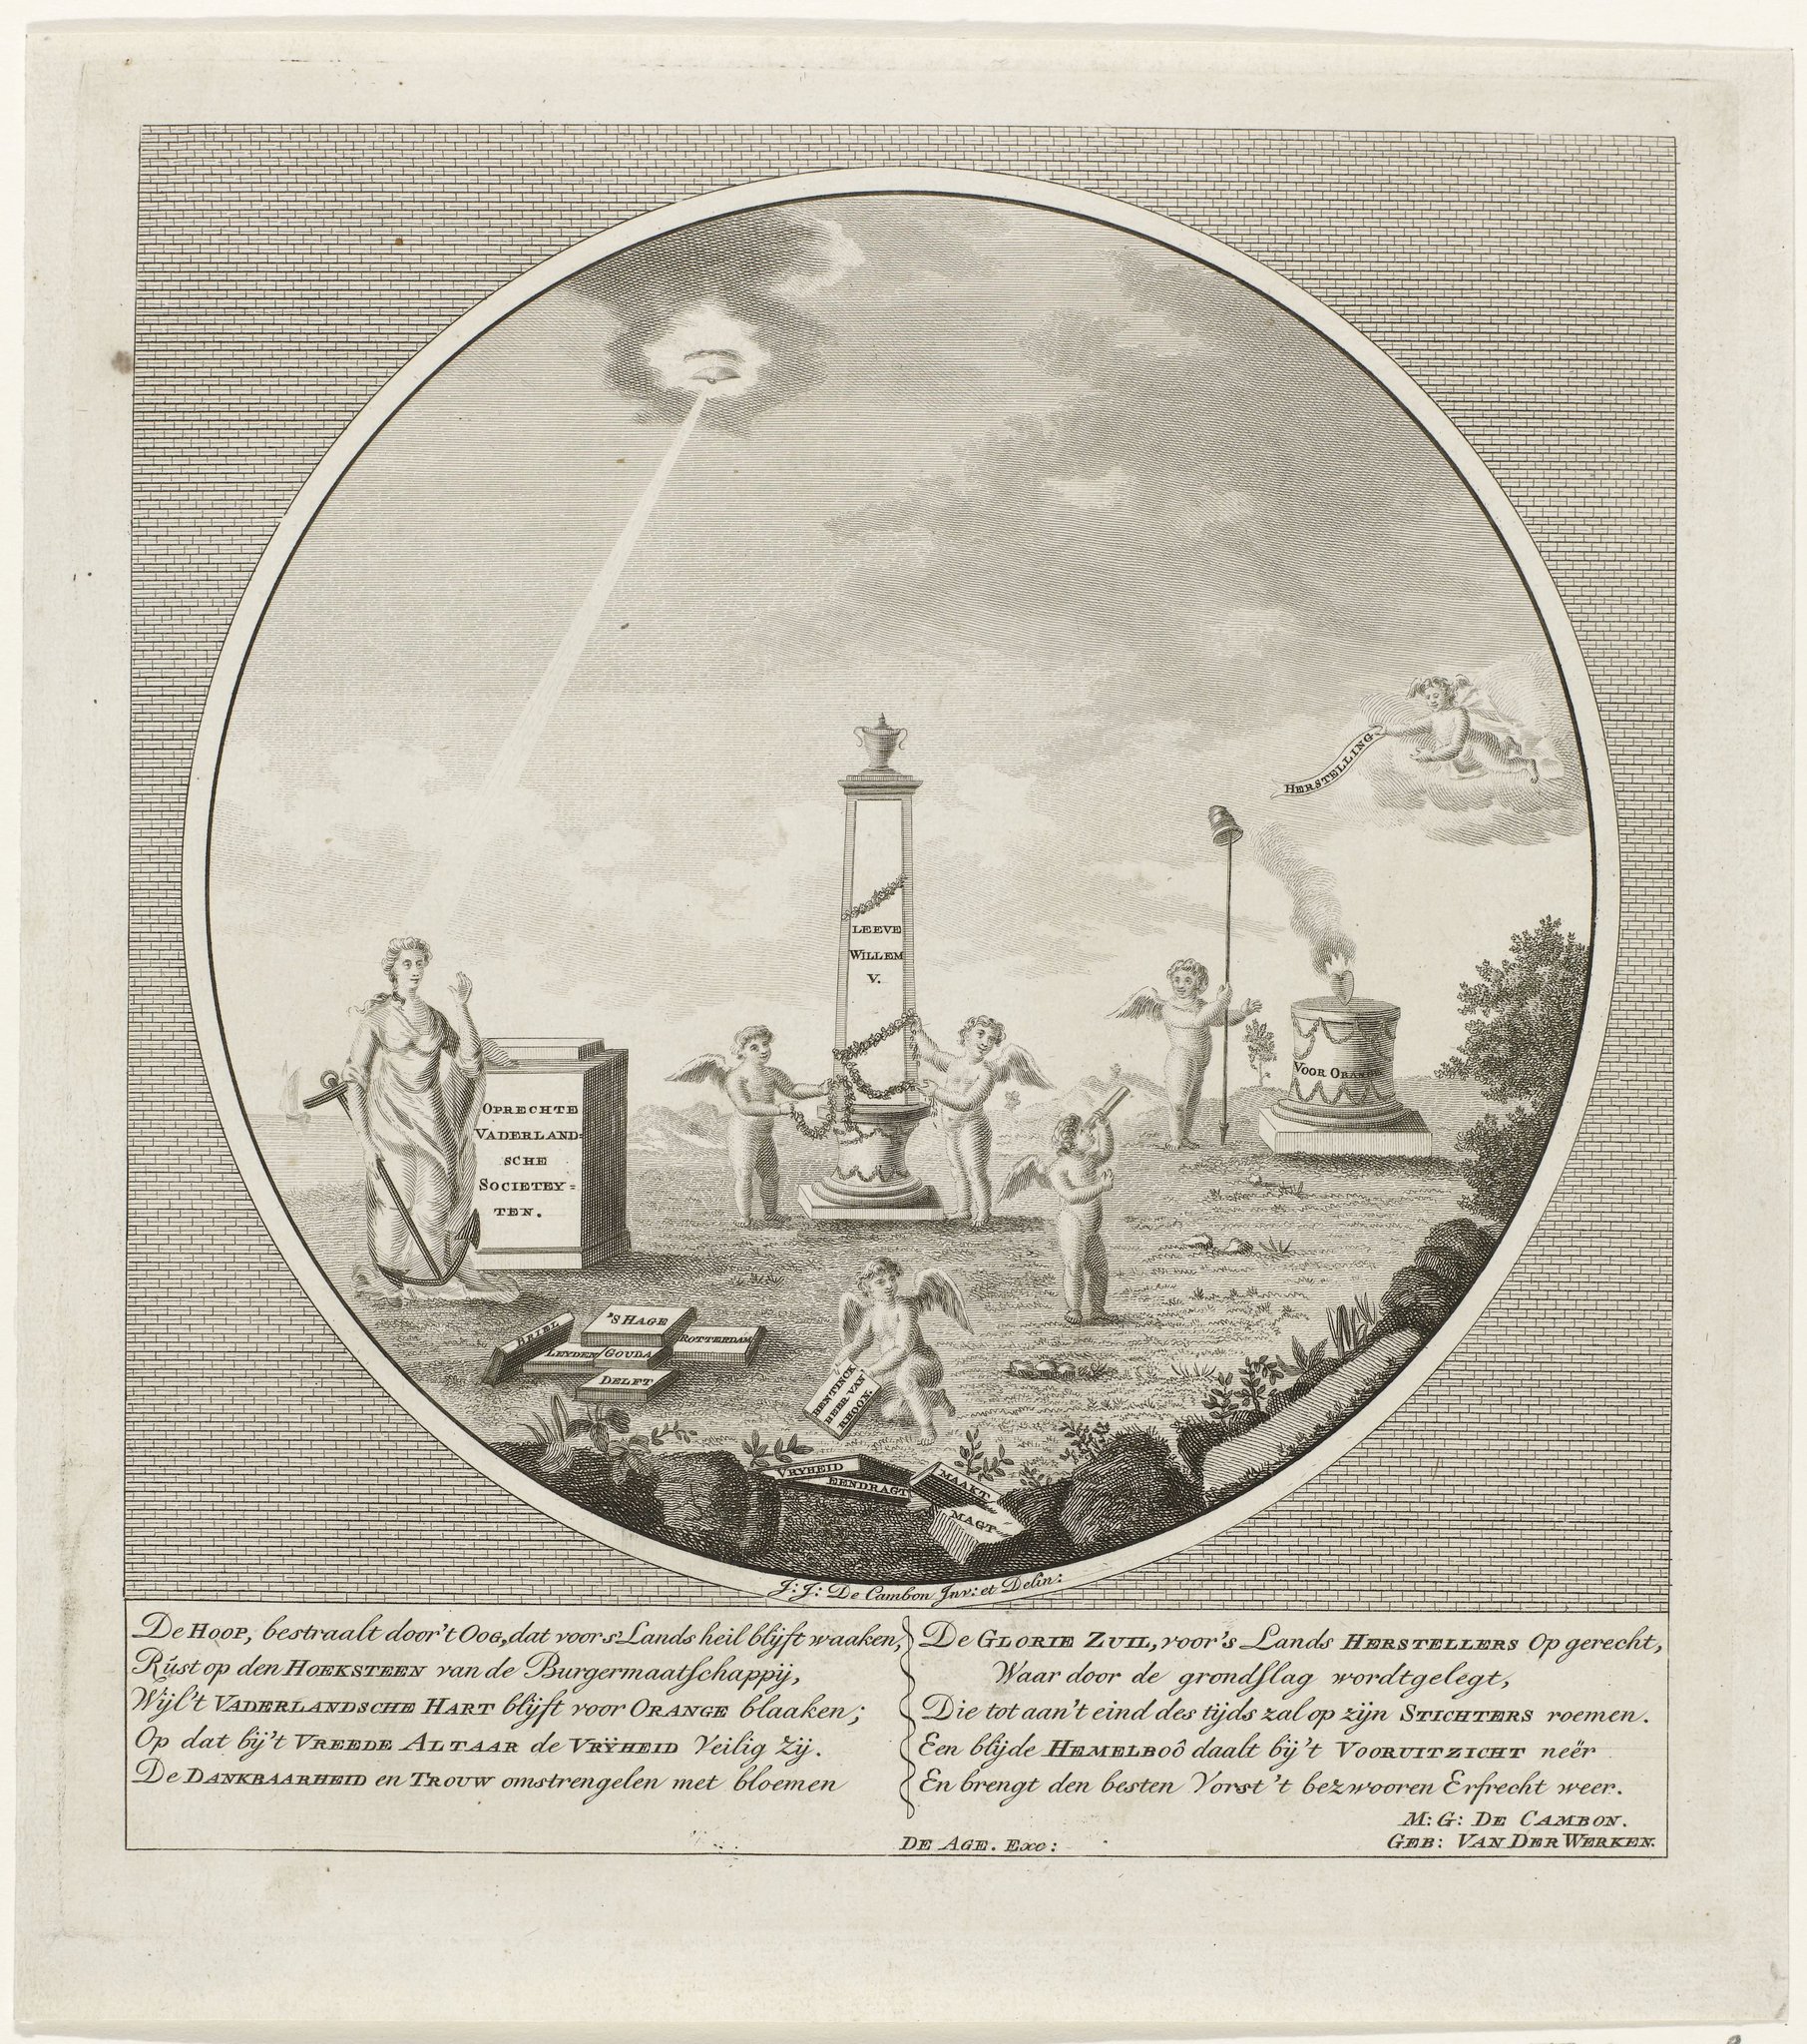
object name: print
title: Allegorie op de oprichting van Oprechte Vaderlandsche Sociëteiten in 1787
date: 1787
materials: paper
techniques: engraving, etching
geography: northern netherlands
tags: the hague, william v (prince of orange), hope, 'spes'; 'speranza divina e certa' (ripa) ~ one of the three theological virtues, the all-seeing eye, triangle with eye ~ symbol of god the father, patriots (1780-1795)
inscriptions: collector's mark: Lugt 2228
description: Allegorie op de oprichting van oranjegezinde Oprechte Vaderlandsche Sociëteiten in 1787. Ronde voorstelling met een tuin met de Hoop staande bij een altaar, verder putti bij een monument ter ere van prins Willem V en een altaar "Voor Oranje" waarop een brandend hart. De Hoop wordt beschenen vanuit de hemel door het Hemels Oog. Op de grond boeken met de namen van de plaatsen waar al sociëteiten zijn opgericht: Den Haag, Rotterdam, Delft, Gouda, Leiden en Brielle. In het onderschrift een vers van tien regels.